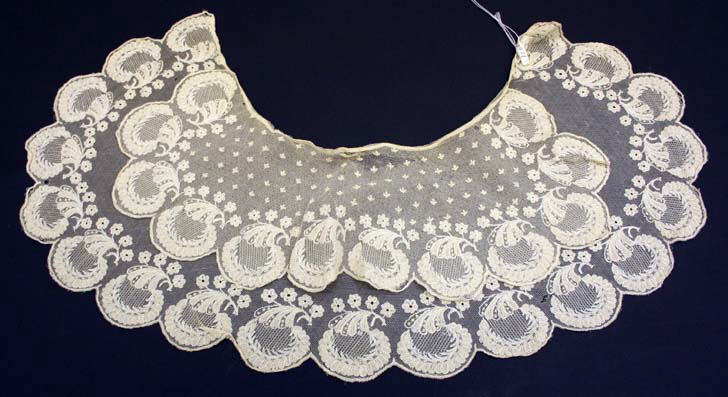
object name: collar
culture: british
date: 1825-1830